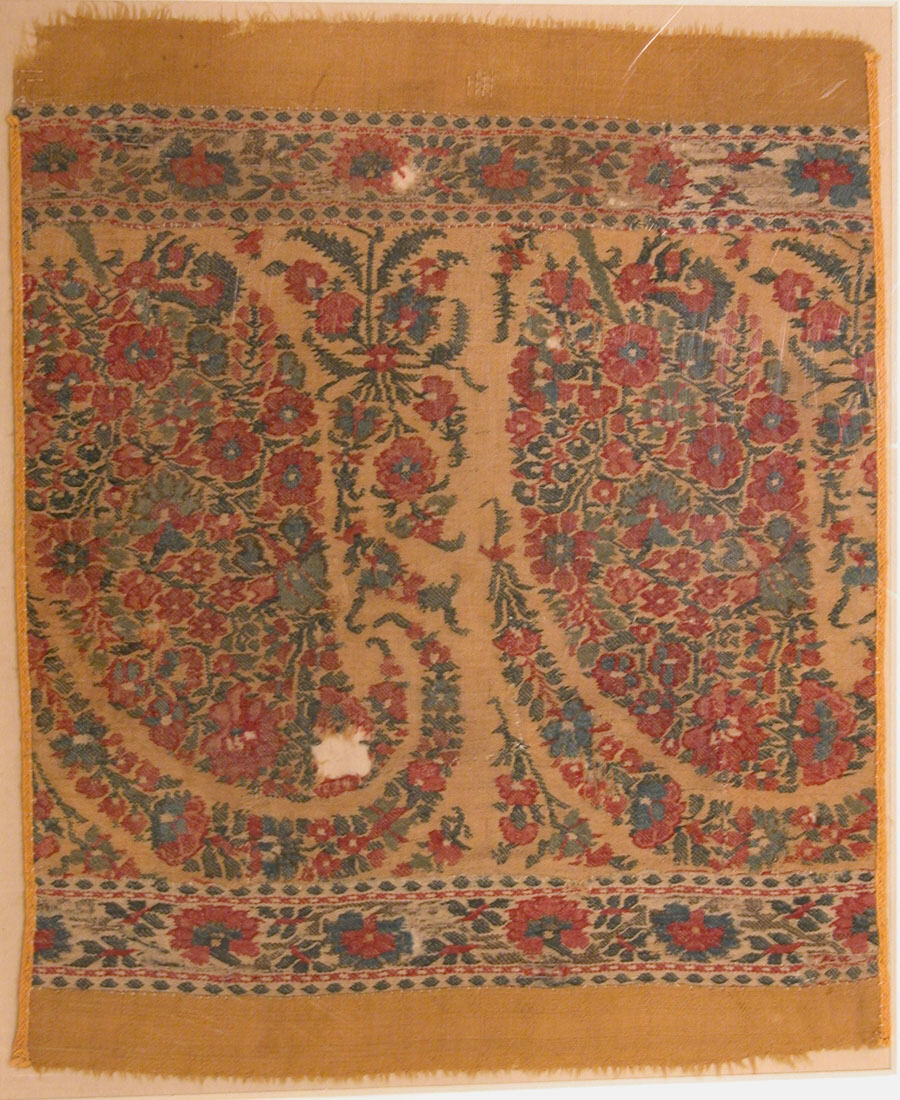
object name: textile fragment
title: Fragment of Shawl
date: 1801-1833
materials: wool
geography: india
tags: flowers,leaves